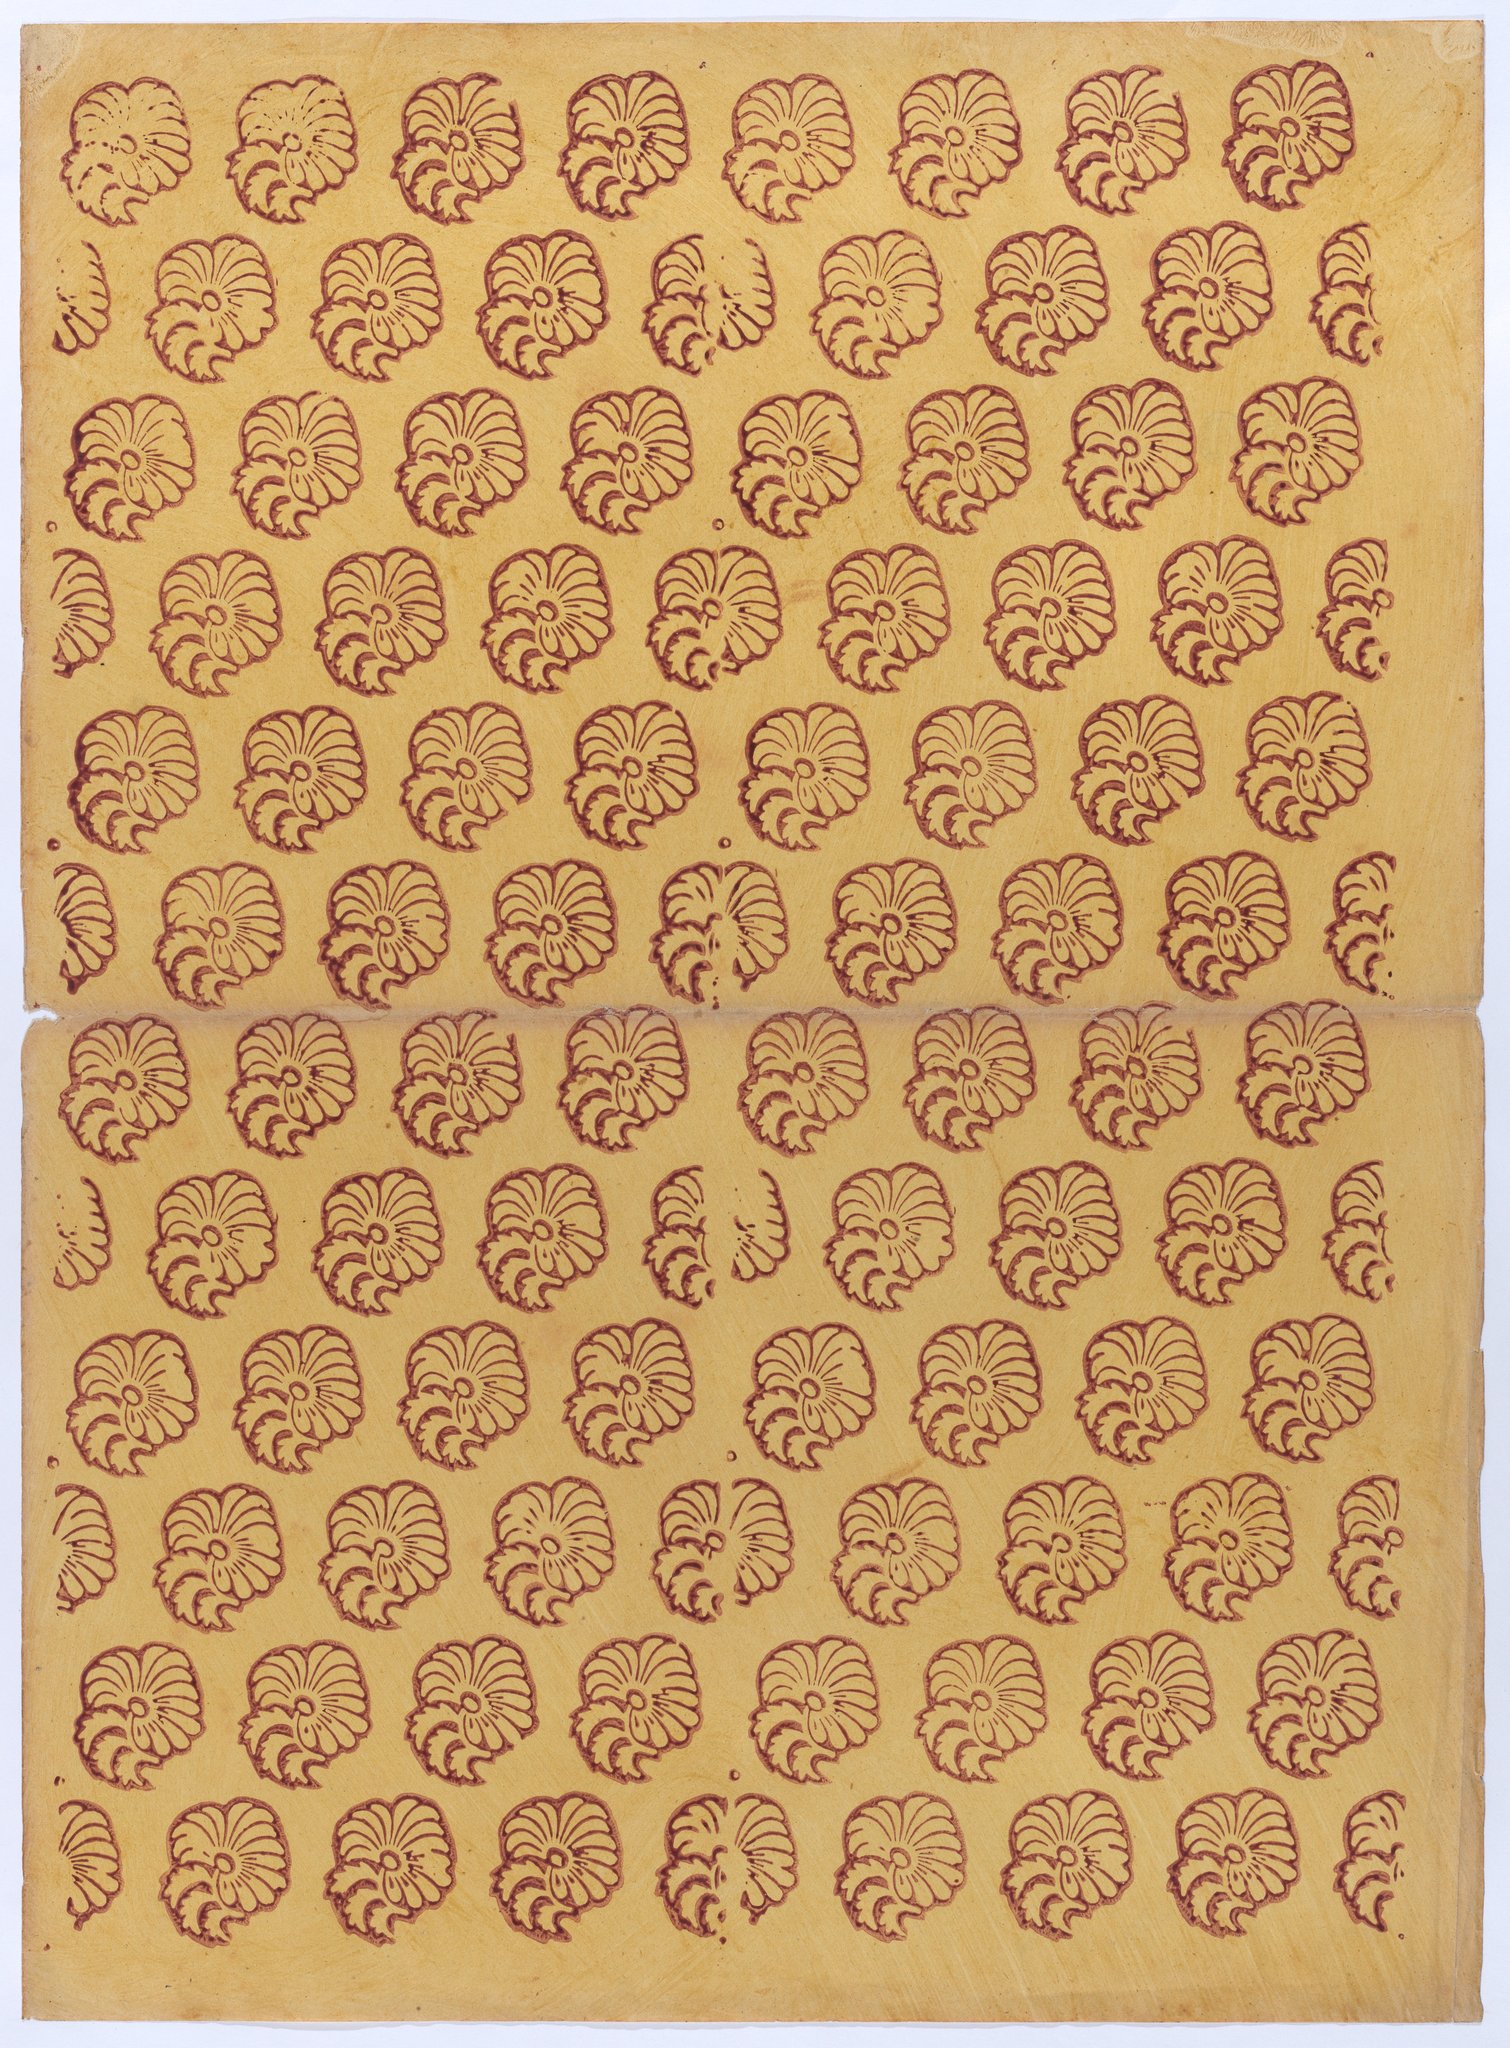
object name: print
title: Yellow sheet with overall red abstract pattern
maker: Anonymous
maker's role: artist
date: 1801-1900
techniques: relief print